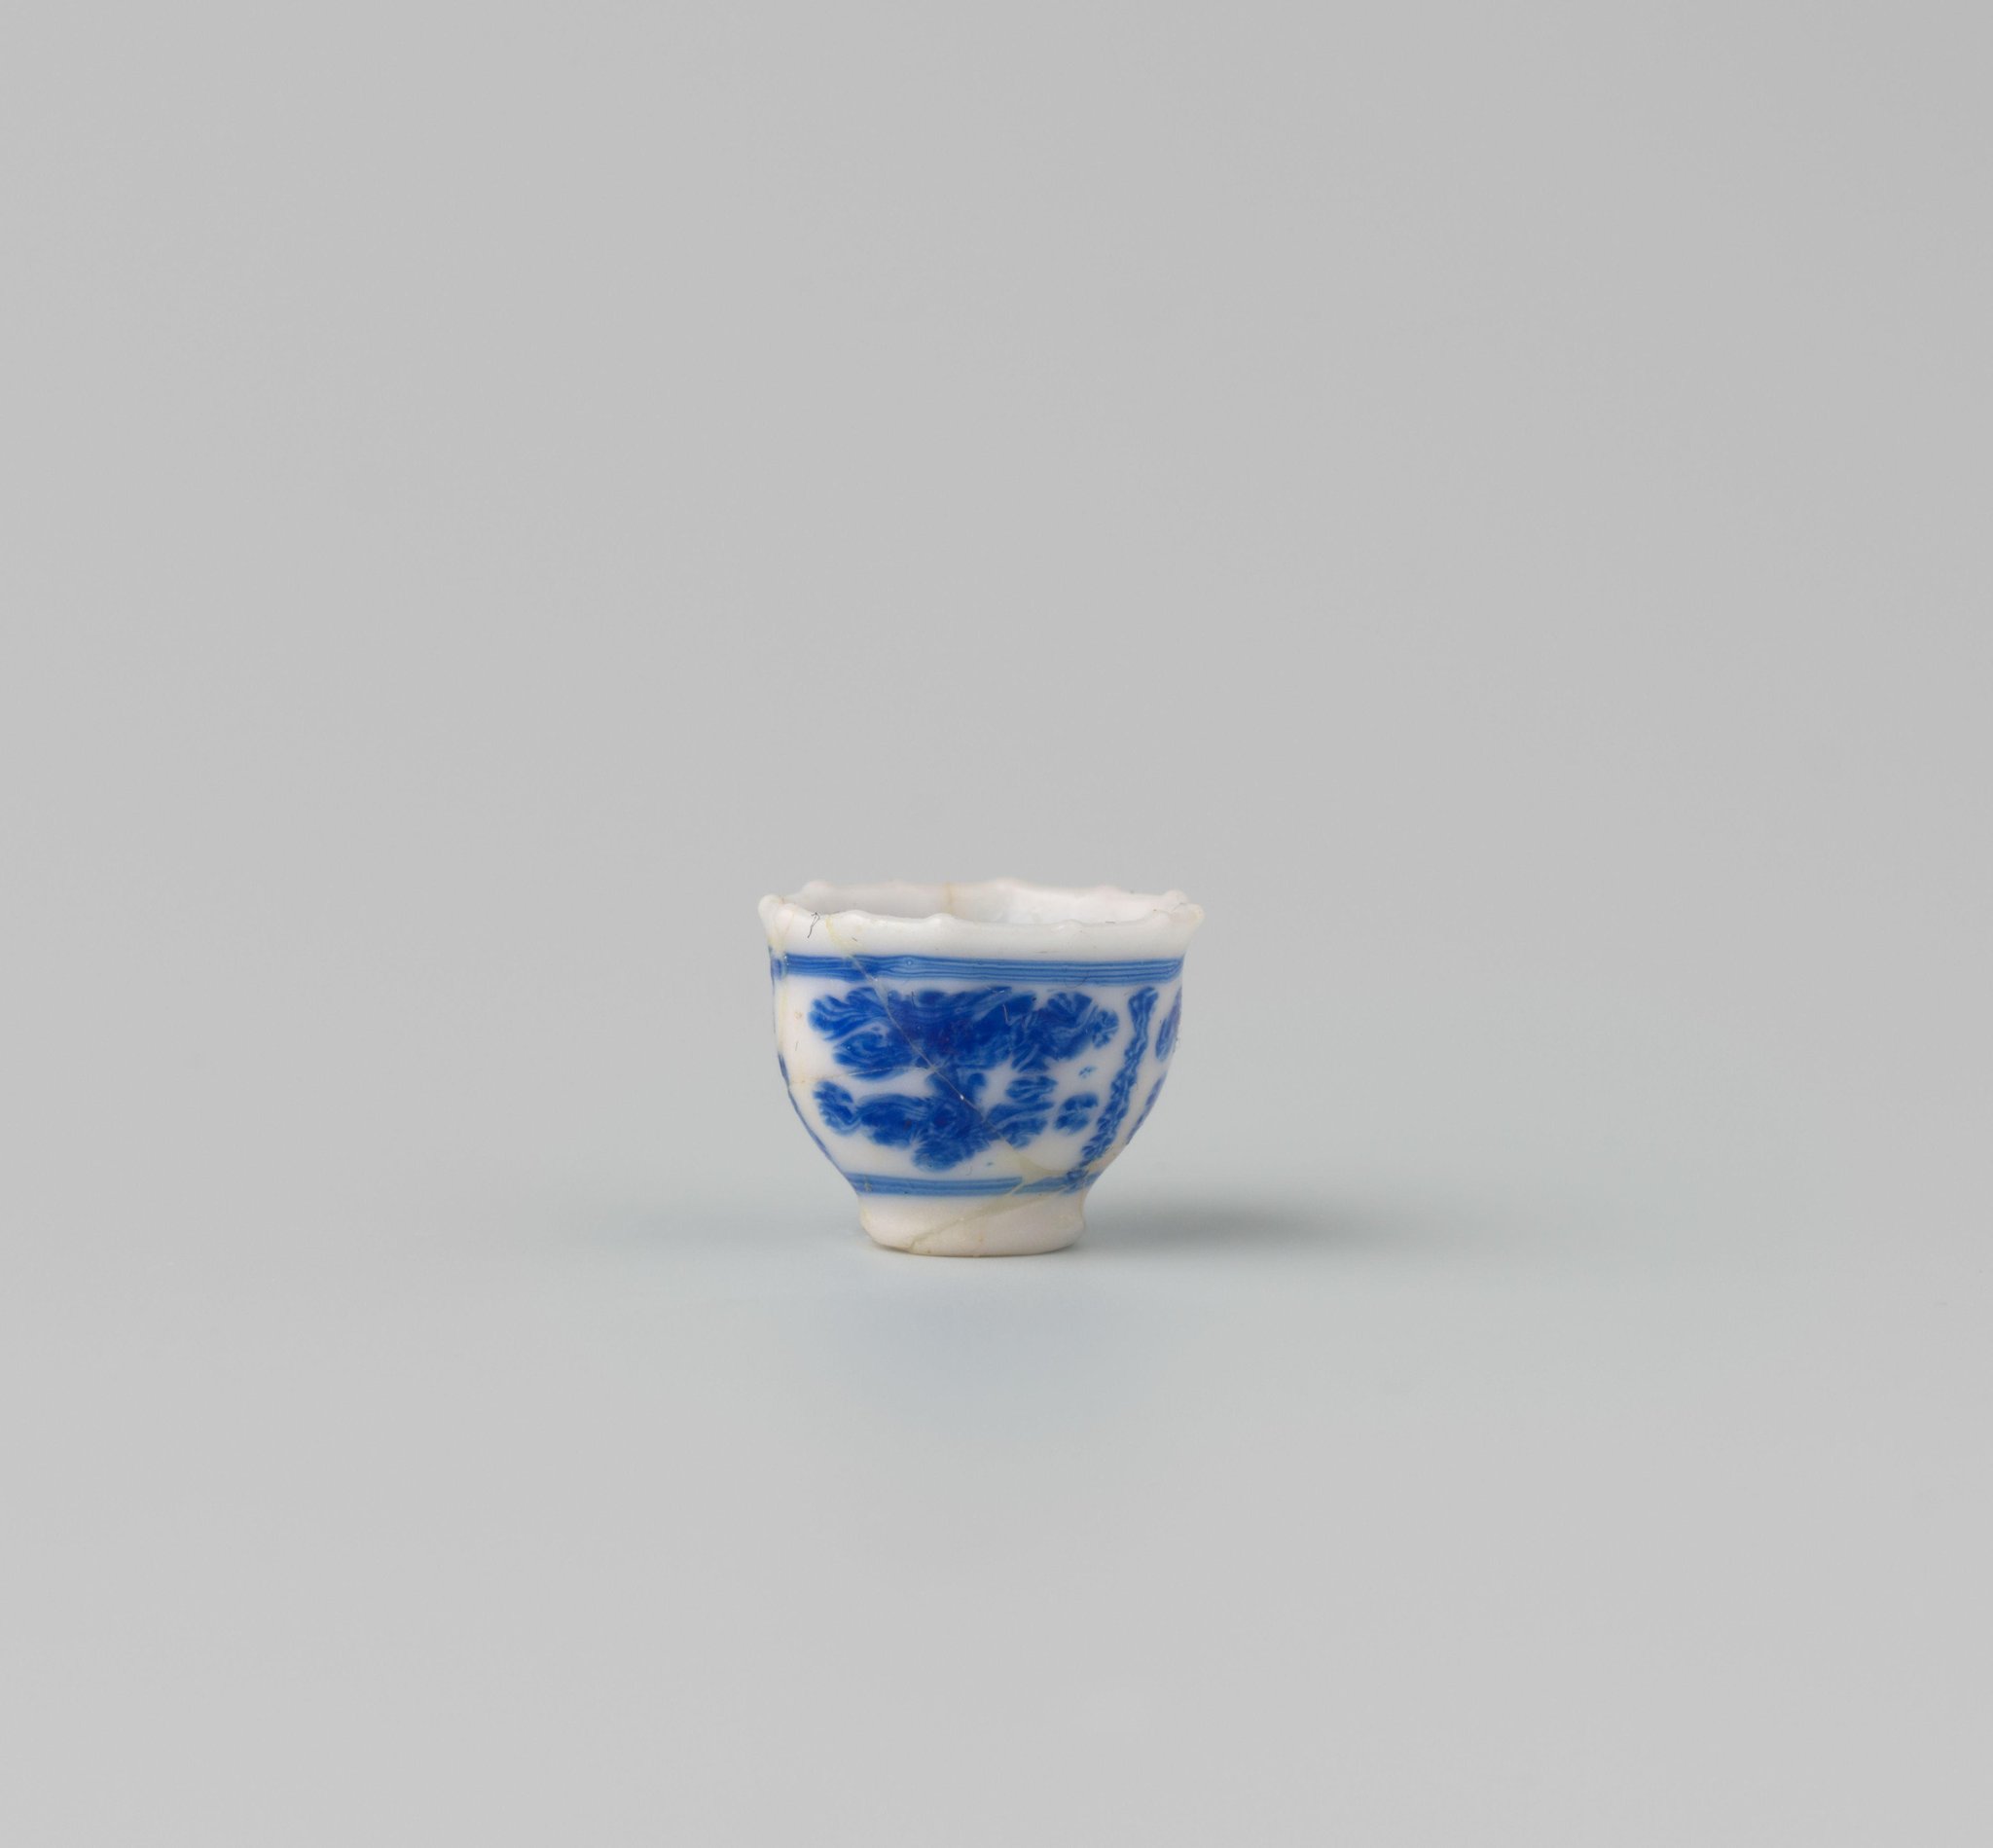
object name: cup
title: Theekopje van melkglas met blauwe emailverf beschildering, imitatie Chinees porselein met 'bloem' decoratie in drie vakken; model met puntrand, nauwelijks een standring.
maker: Anonymous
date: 1675-1710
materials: glass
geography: amsterdam